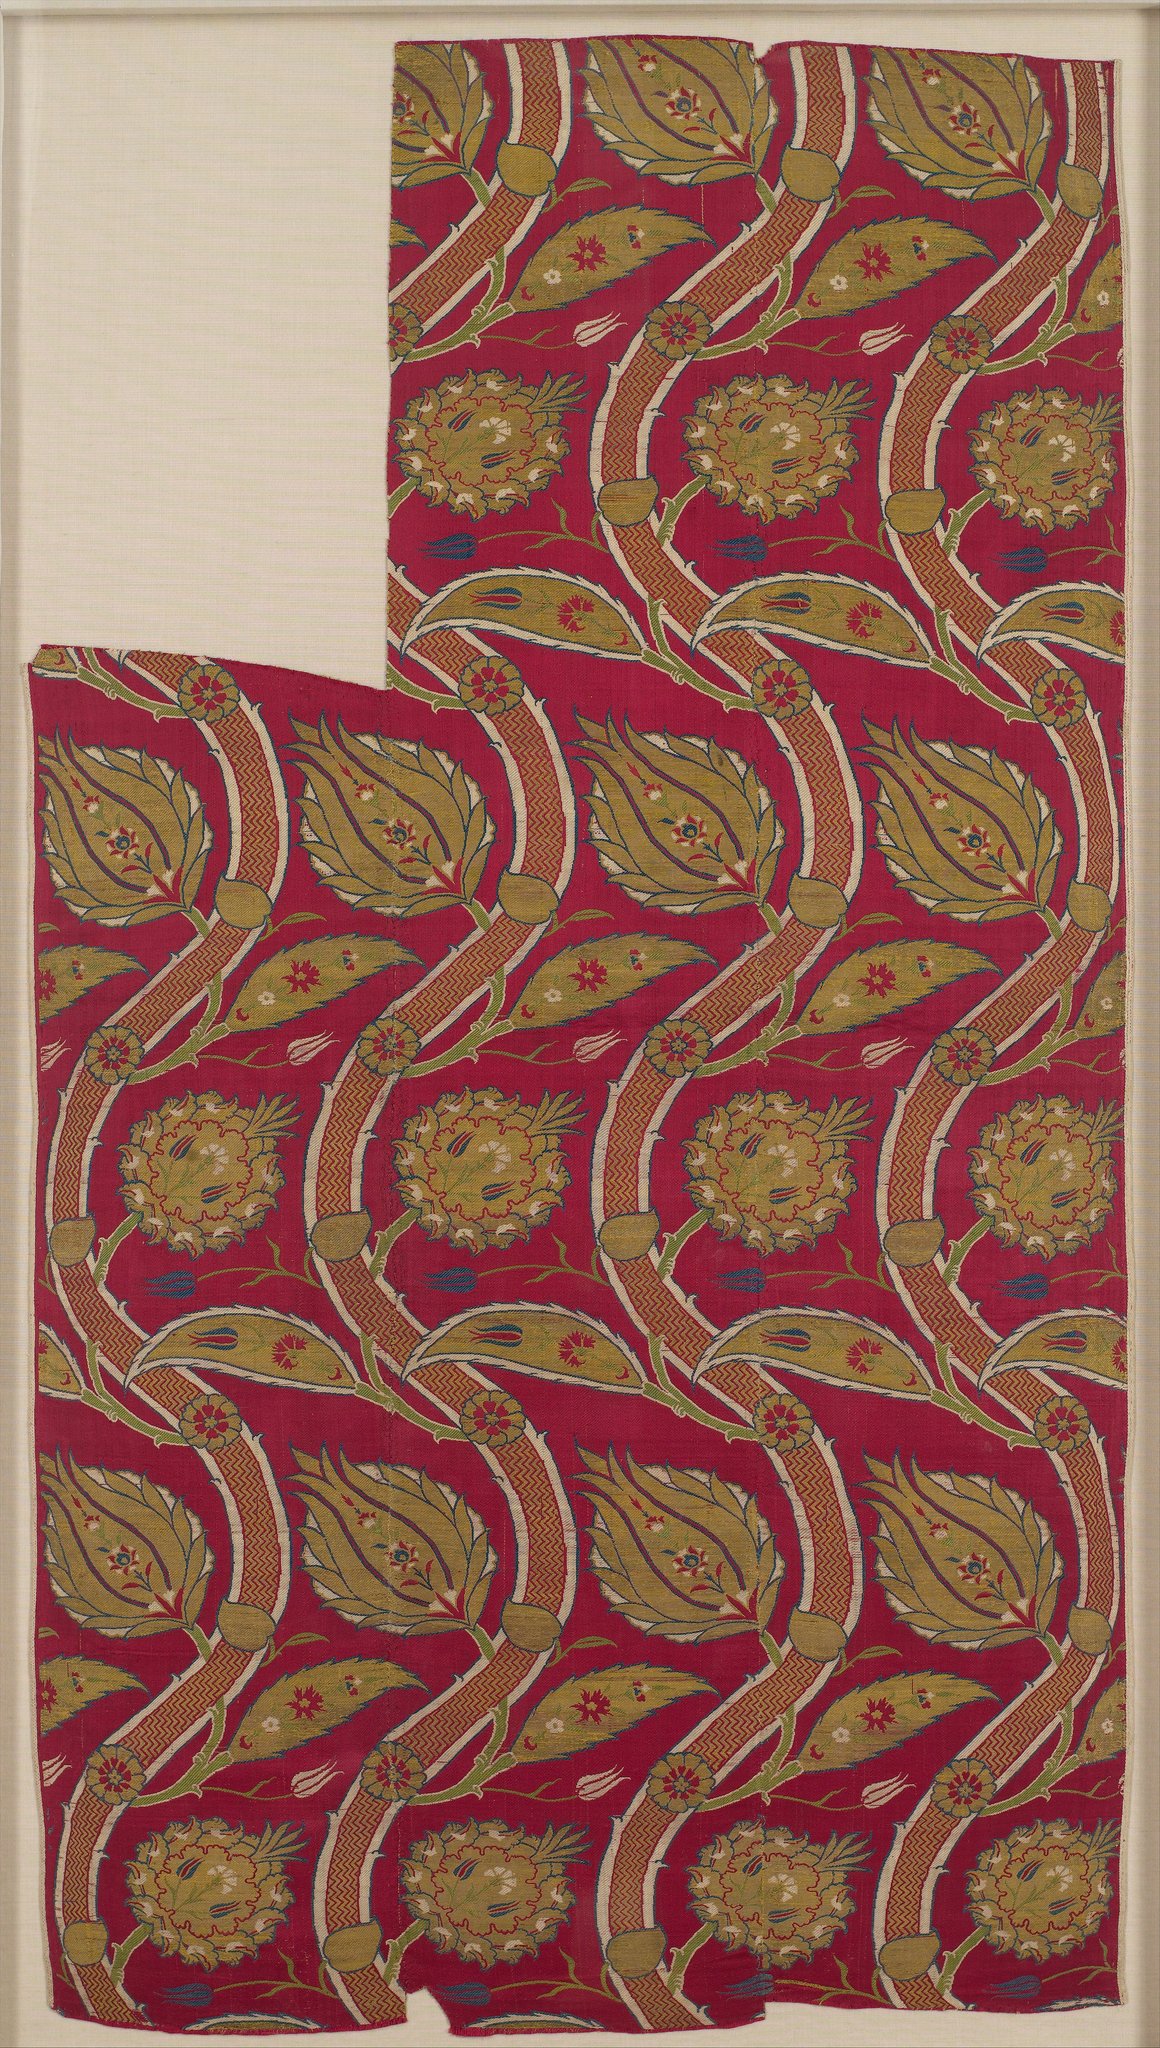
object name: textile fragment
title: Fragmentary Loom Width with Wavy-Vine Pattern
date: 1565-1580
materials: metal thread, silk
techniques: lampas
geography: turkey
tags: vines